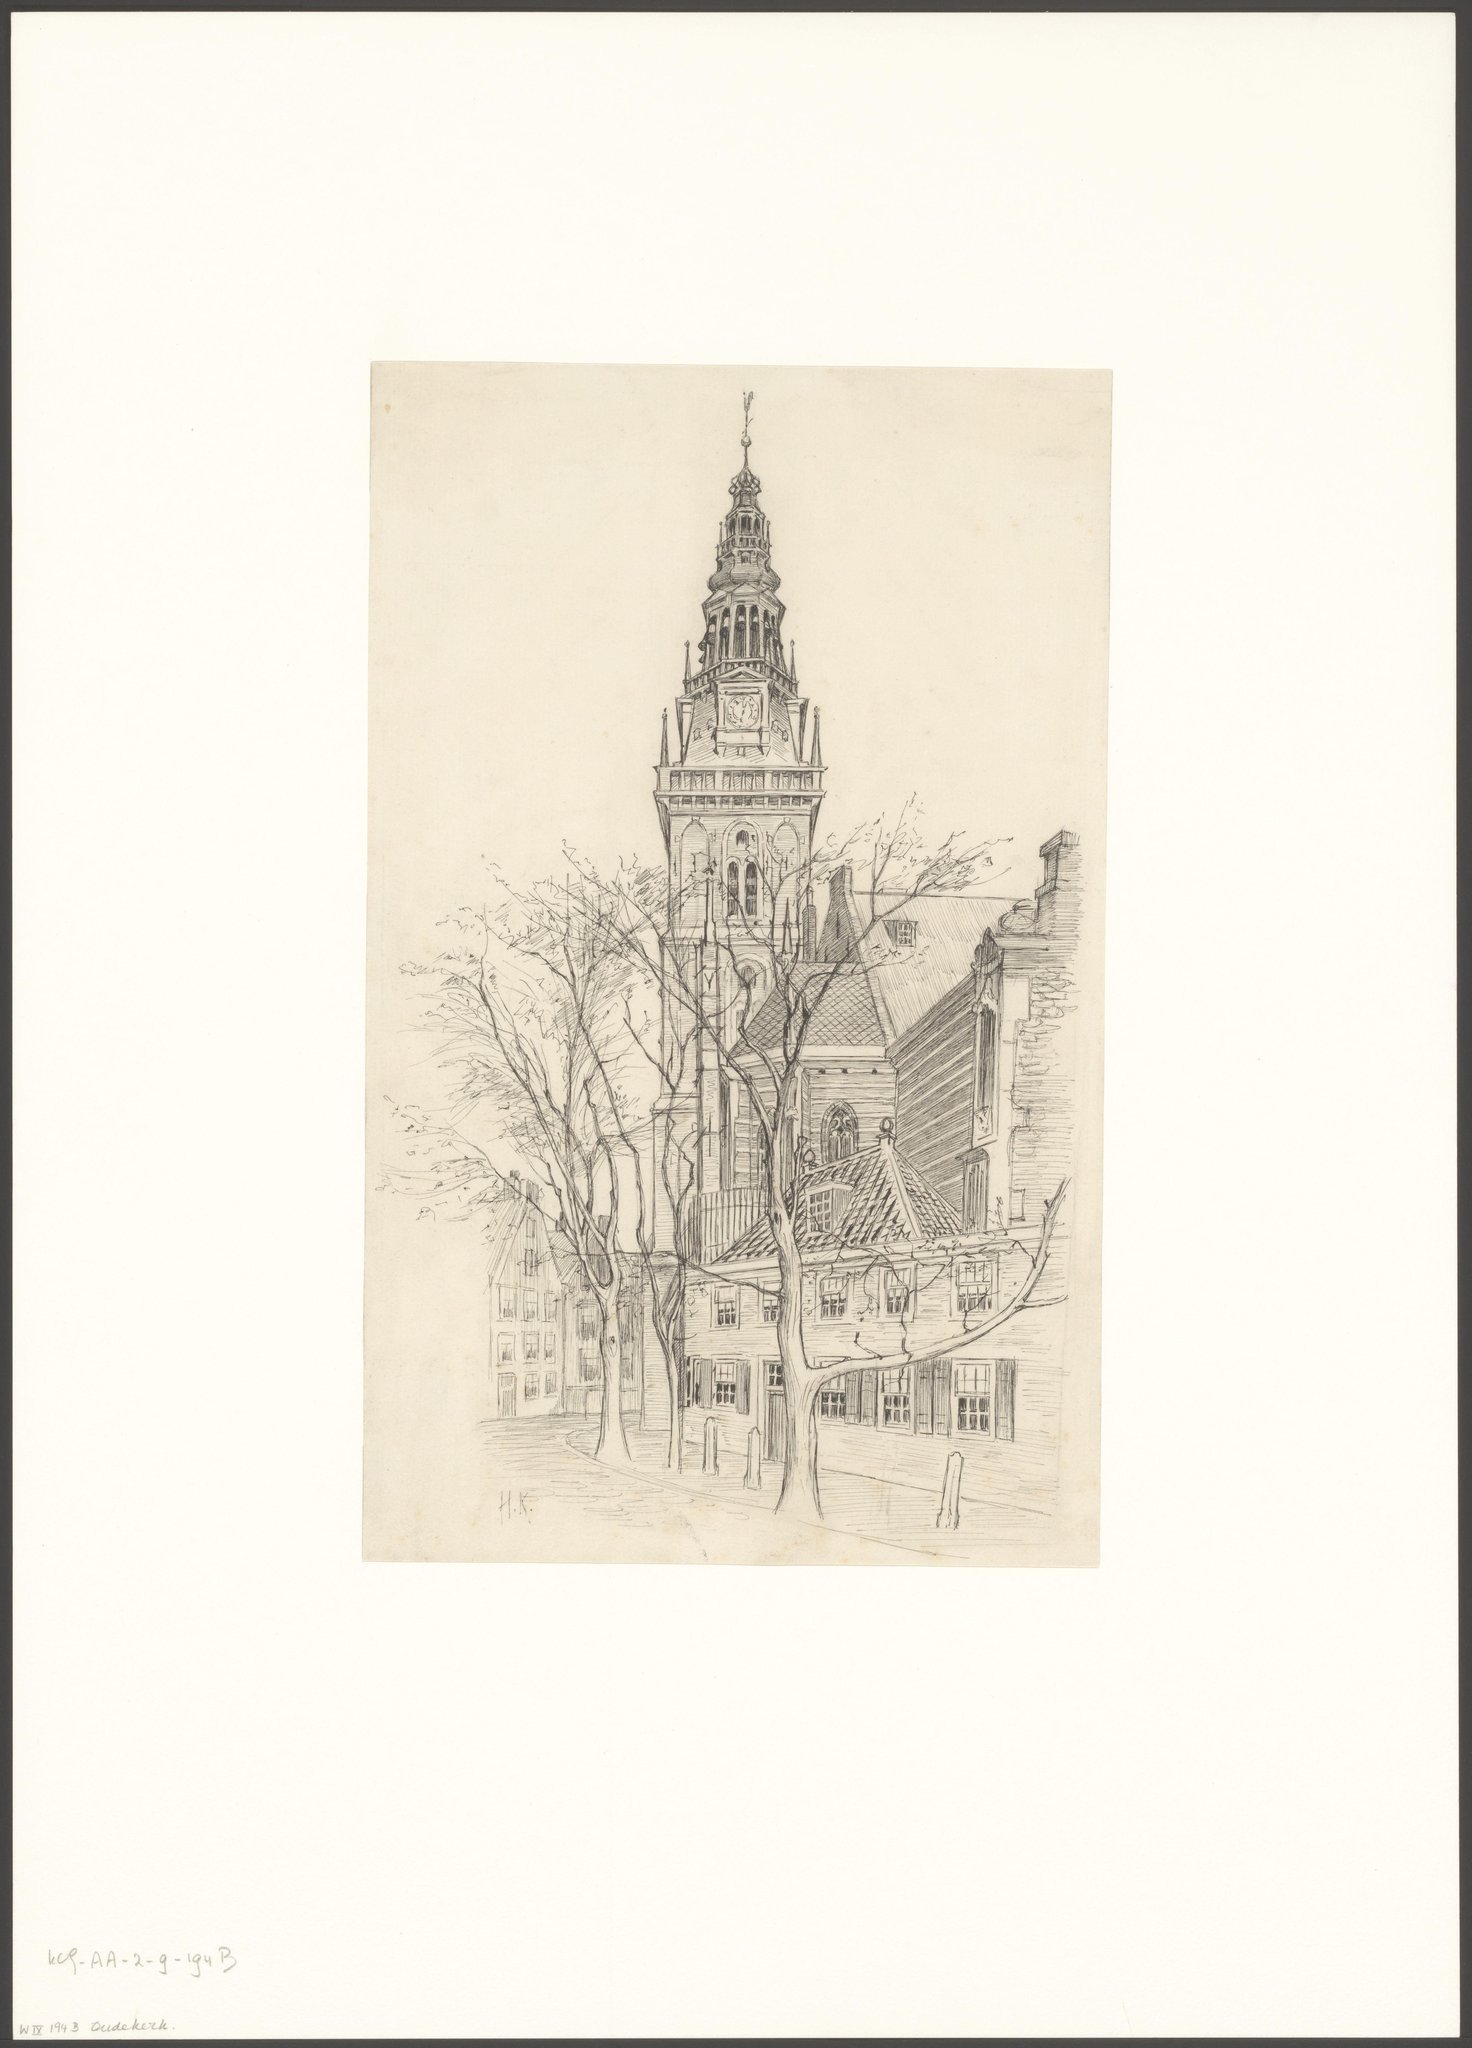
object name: drawing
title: Gezicht op de zuidzijde van de Oude Kerk met de toren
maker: hendrik klijn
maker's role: print maker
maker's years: 1860-1929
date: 1870-1929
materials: ink, paper, pencil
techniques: pen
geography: amsterdam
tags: city-view in general; 'veduta', parts of church exterior and annexes: apse, parts of church exterior and annexes: spire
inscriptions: signature: ‘H.K.’, name: ‘Hendrik Klyn’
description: Tekening binnen de Atlas Van Eck ingedeeld op wijknummer 9.